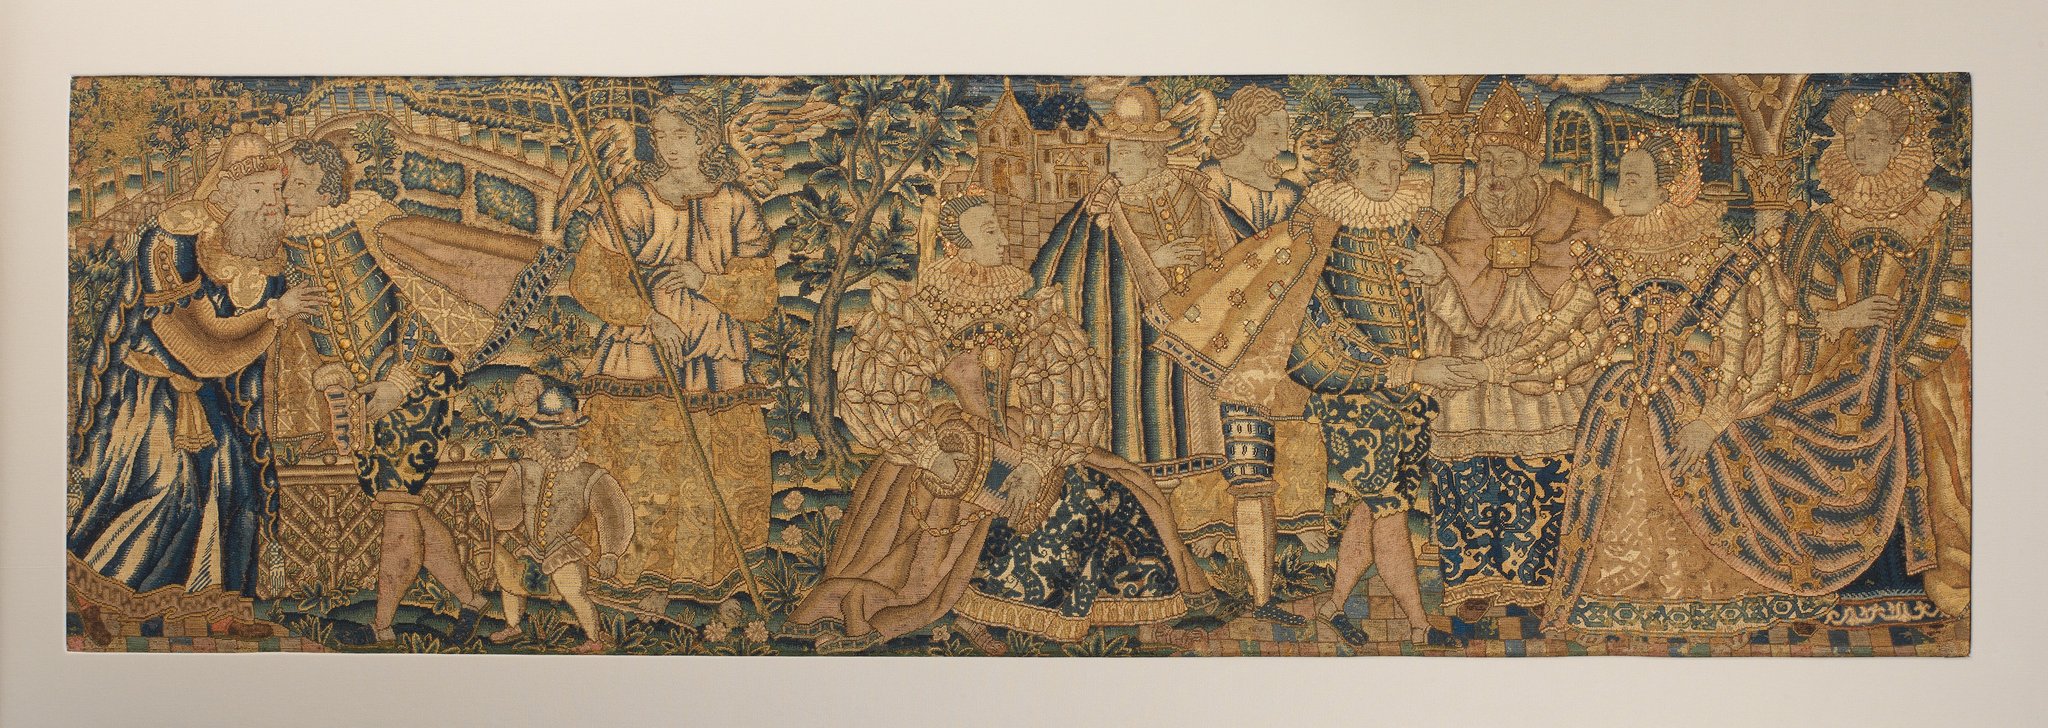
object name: valance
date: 1576-1600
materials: canvas, silk, wool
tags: men,women,angels